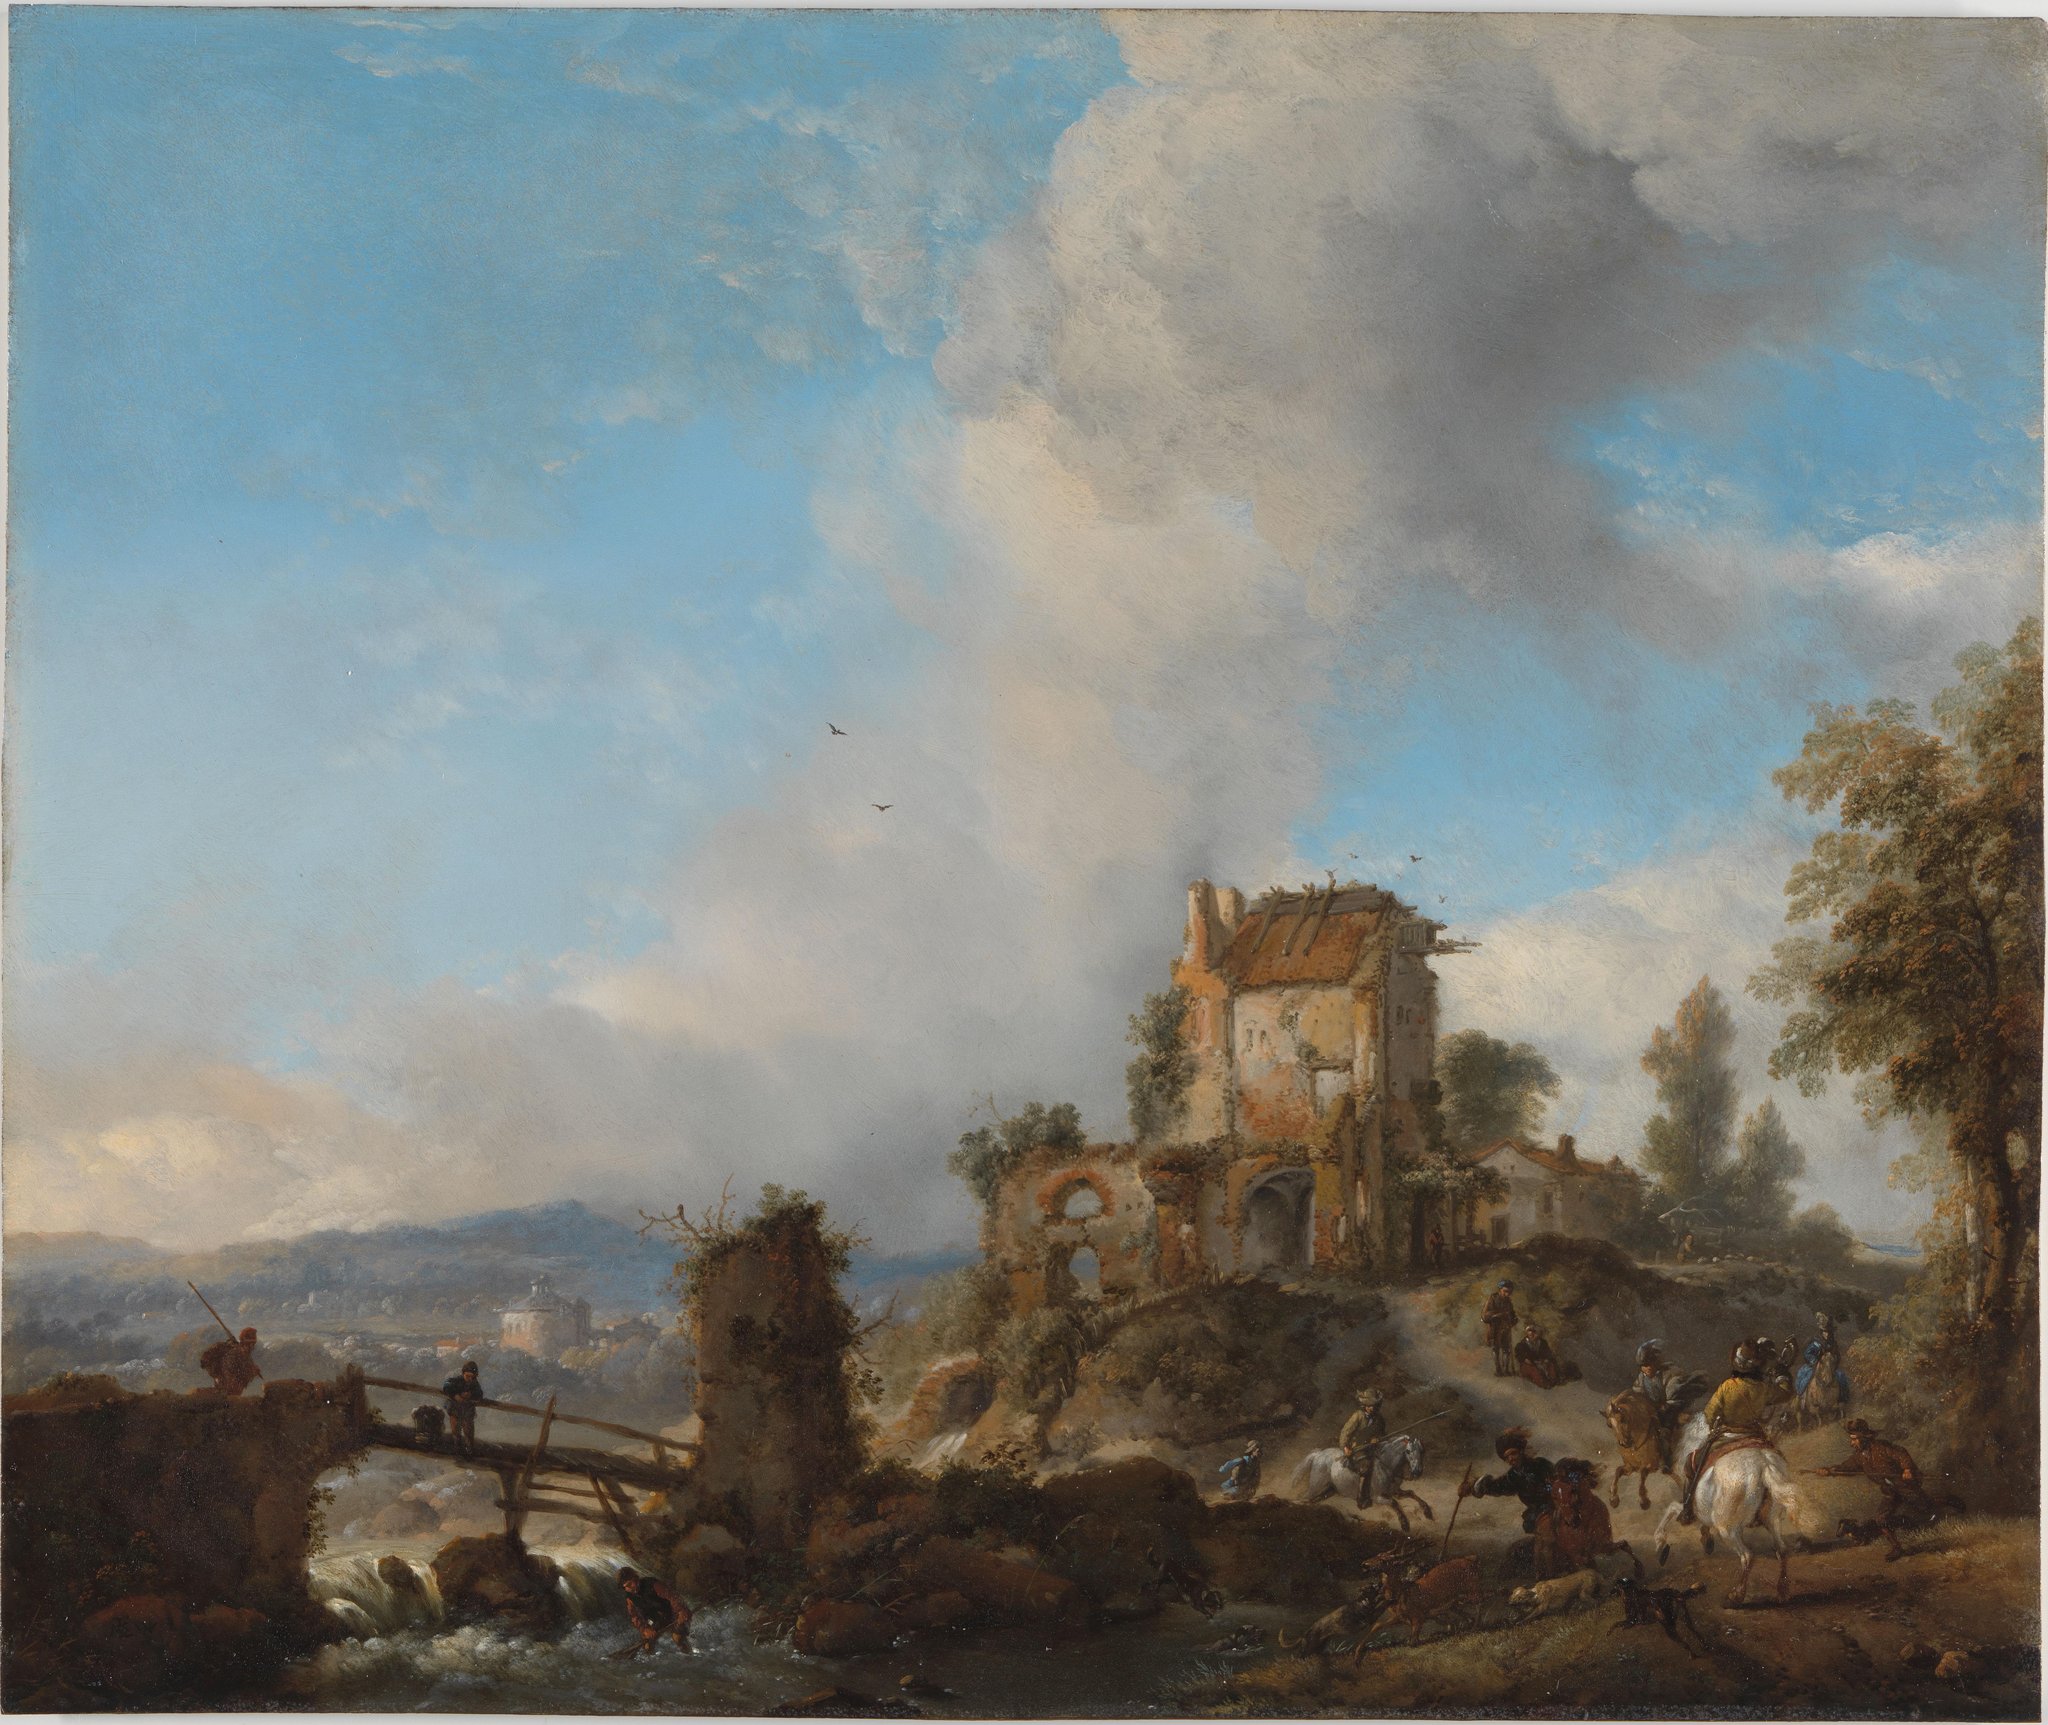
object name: painting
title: The Stag Hunt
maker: philips wouwerman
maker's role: draughtsman, painter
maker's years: 1619-1668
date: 1655-1656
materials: copper, oil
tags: stag-hunting, landscape with ruins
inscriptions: signature, with monogram, bottom left (letters of first name ligated): ‘PHils . W’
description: Hertenjacht. Een hert wordt in een heuvelachtig landschap door jagers en honden gevangen. In het midden de ruïne van de abdij van Rijnsburg, links een houten brug over een watervalletje.